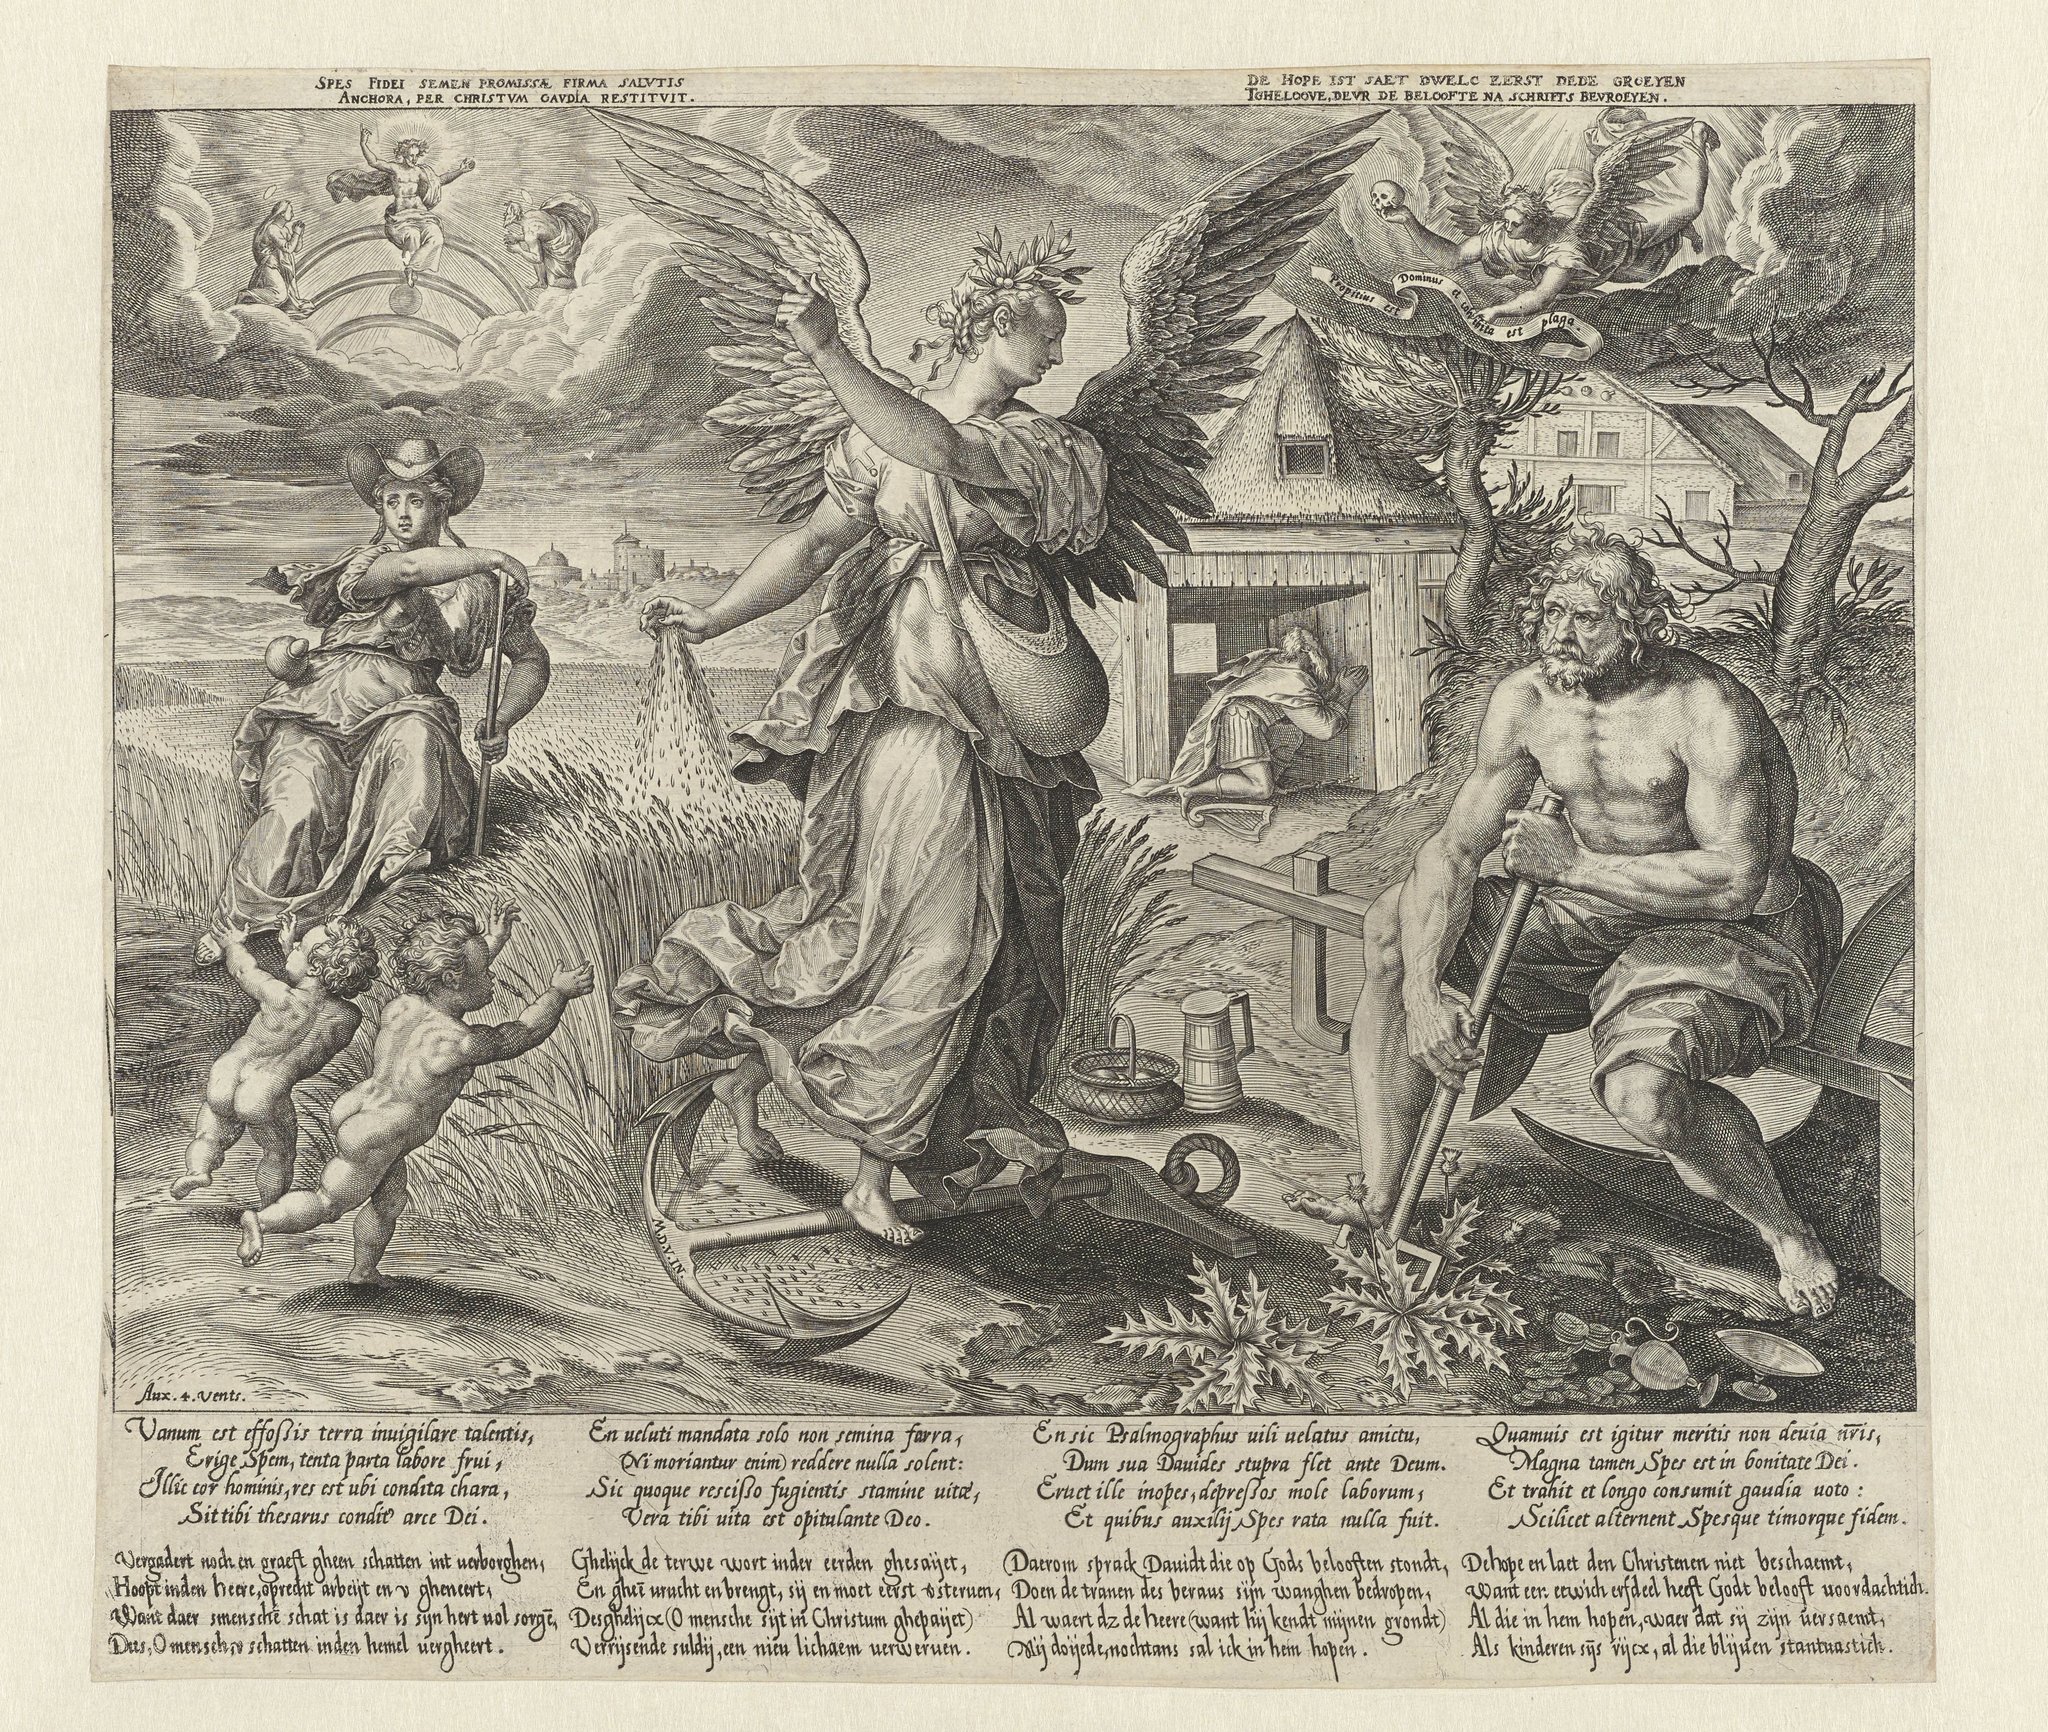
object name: print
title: De vier vijanden van de Ware Gelovige en de goddelijke deugden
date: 1580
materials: paper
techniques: engraving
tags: hope, 'spes'; 'speranza divina e certa' (ripa) ~ one of the three theological virtues, true religion vs. false religion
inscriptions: stamp: Lugt 4099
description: In het midden staat een gevleugelde vrouwengestalte op een anker, lauwerkrans op het hoofd. Ze zaait tarwe en wijst op de hemel. Voor haar een man die met zijn spade een gat graaft tussen de distels om zijn aardse schatten (vaatwerk en geldstukken) in te verbergen. Achter haar een vrouw die het koren maait. Op de voorgrond twee naakte kinderen. Op de achtergrond de berouwvolle koning David, geknield in gebed in een houten schuur. Linksboven Christus op een regenboog in de wolken, aanbeden door Maria en Johannes. Rechtsboven een engel met doodshoofd in de hand in de wolken. Met onderschrift van 4 kolommen in elk 4 regels Latijn en 4 regels Nederlands. Tweede prent uit serie met vier allegorieën op het Geloof. Derde prent uit serie met Allegorieën op de Deugden en het Geloof.